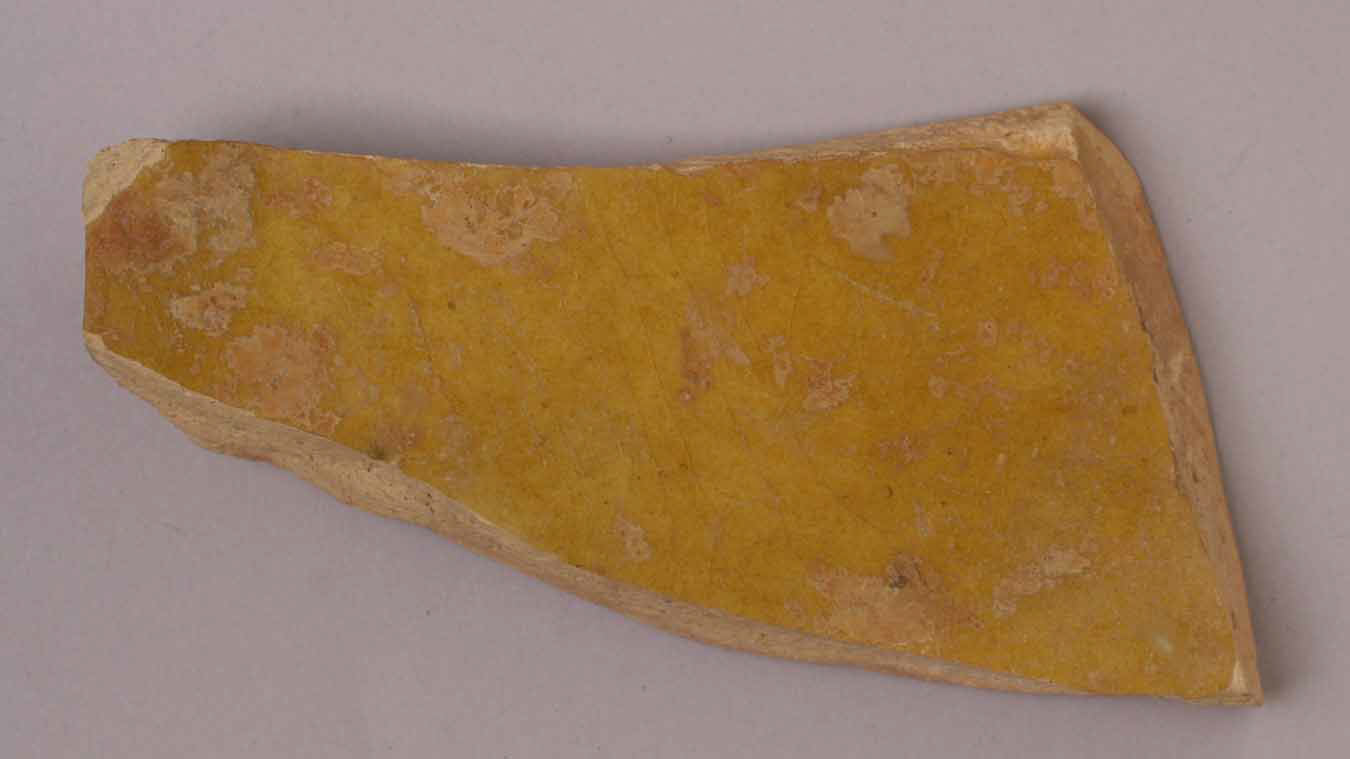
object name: fragment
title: Ceramic Fragments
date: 801-900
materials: earthenware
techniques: glazing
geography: iraq